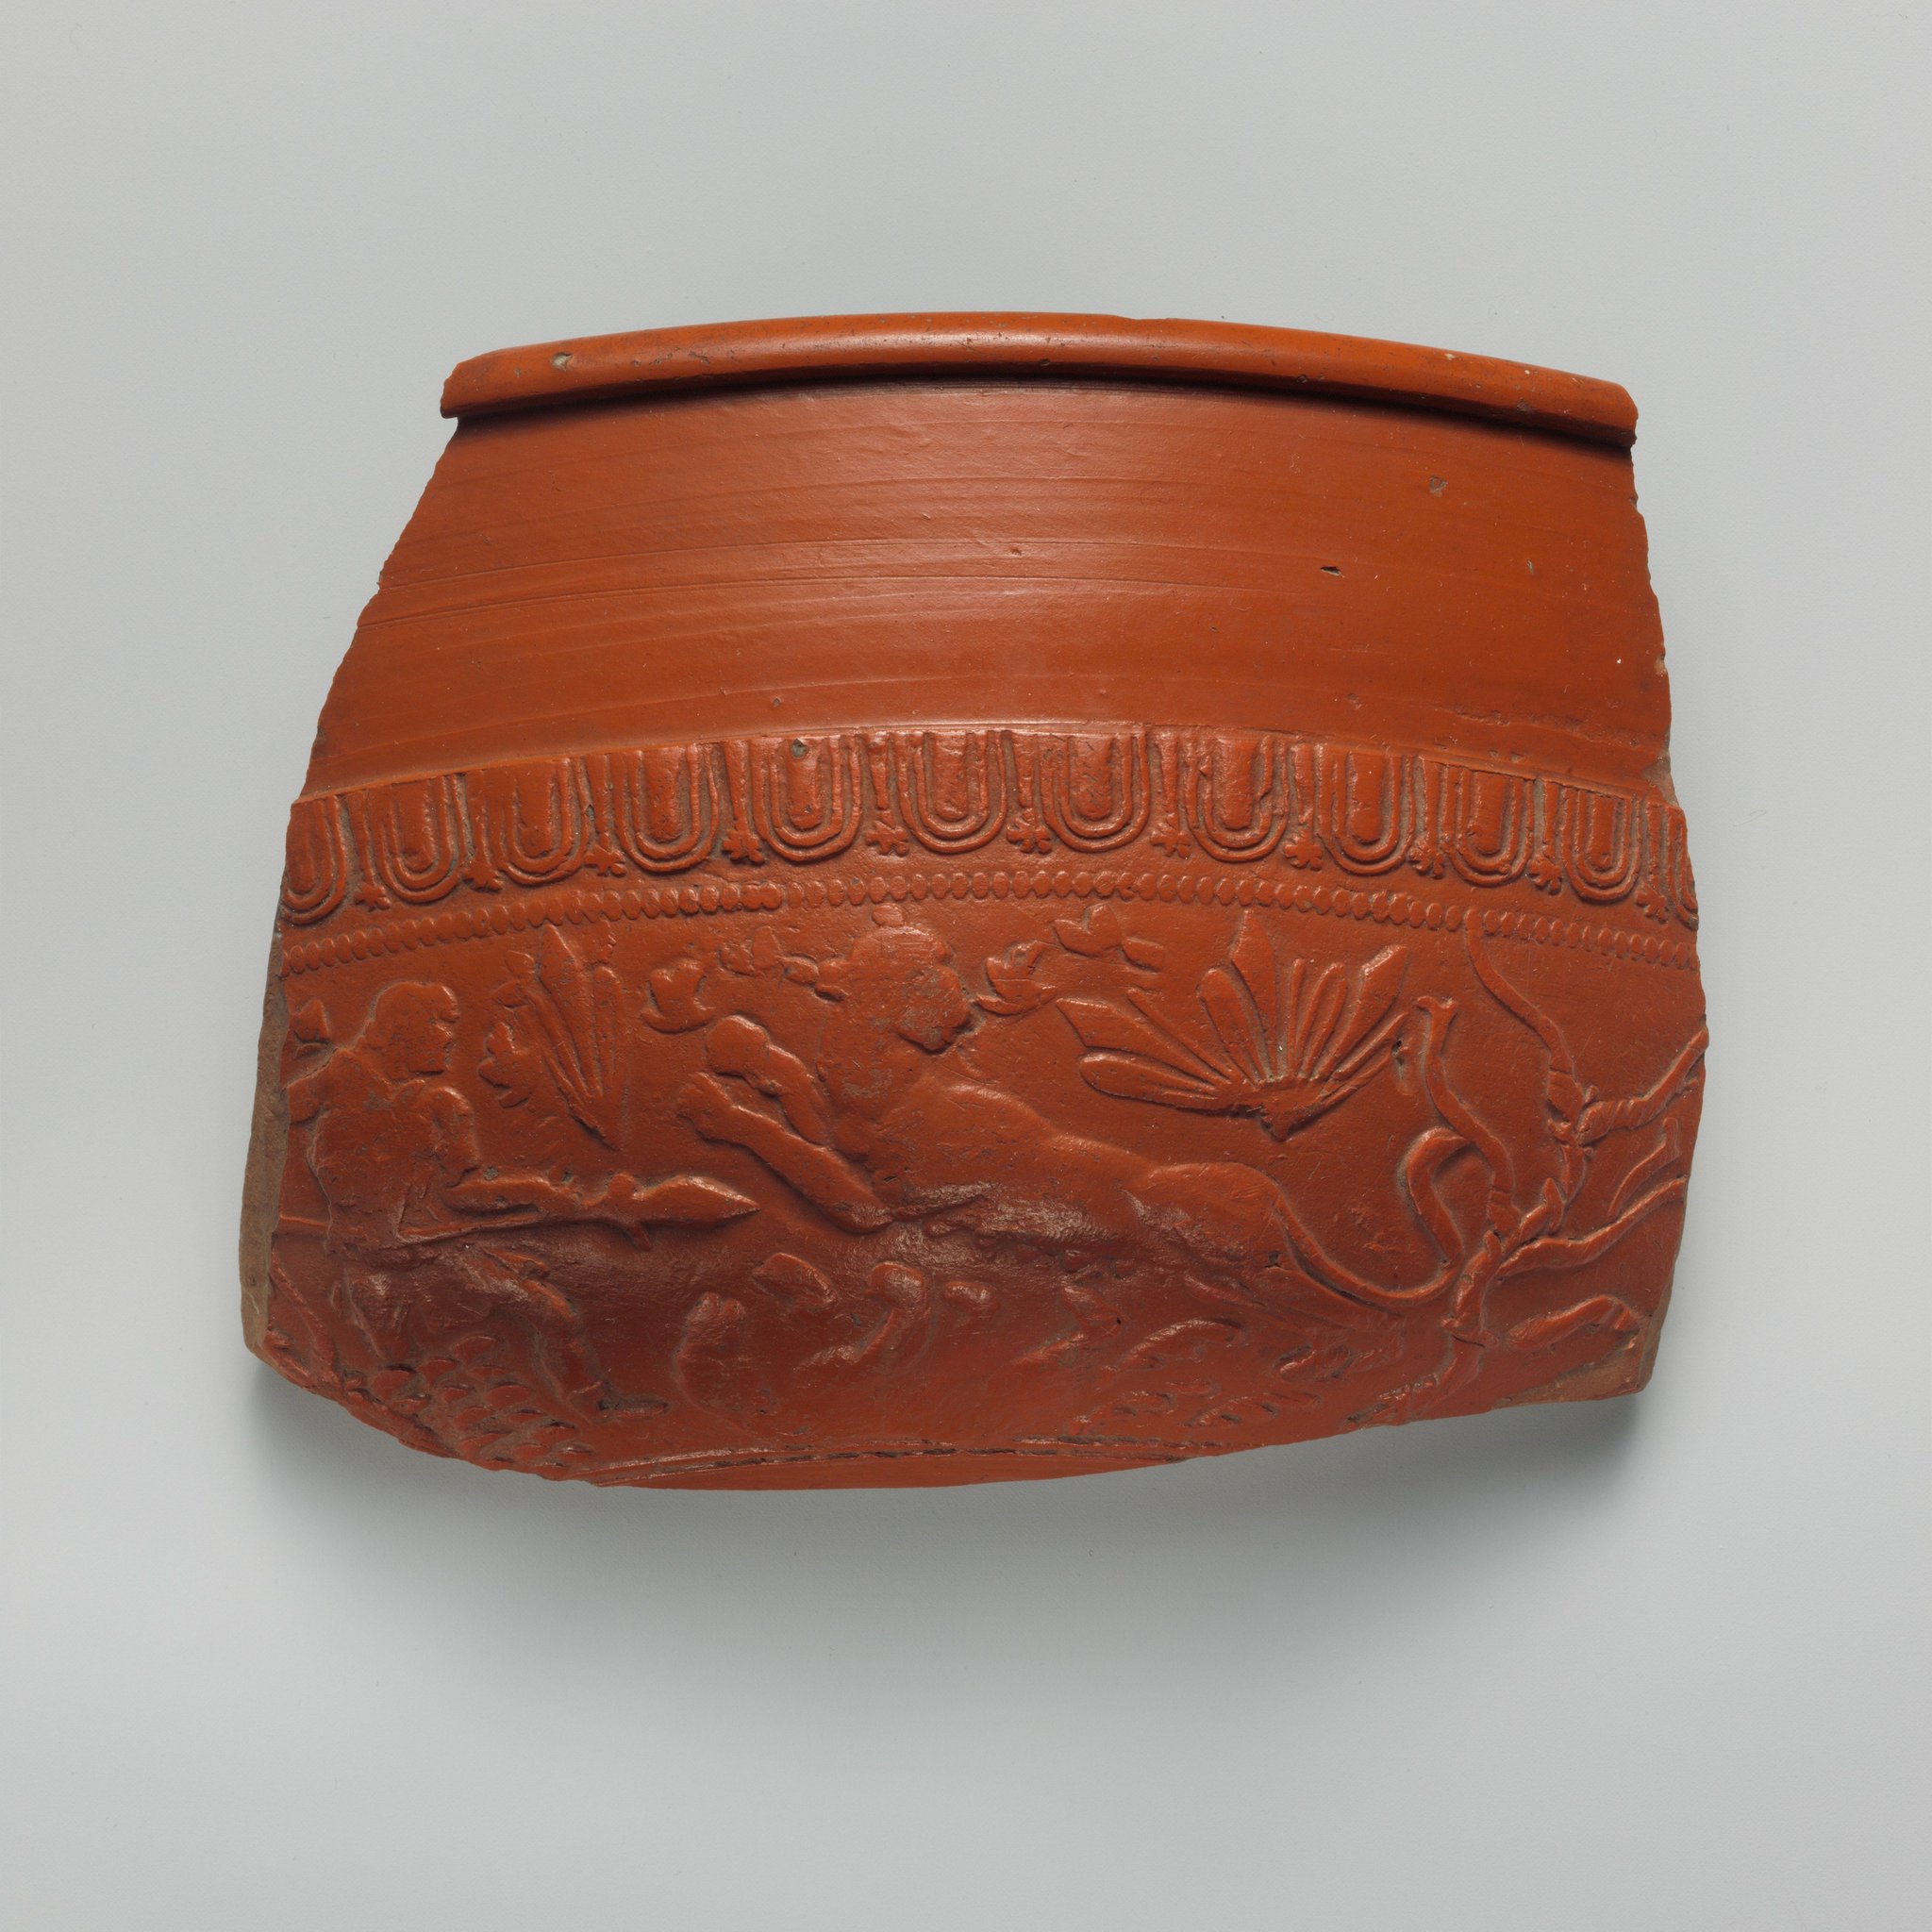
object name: vase fragment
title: Terracotta bowl fragment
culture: roman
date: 101-200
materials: terracotta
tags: men,hunting,lions